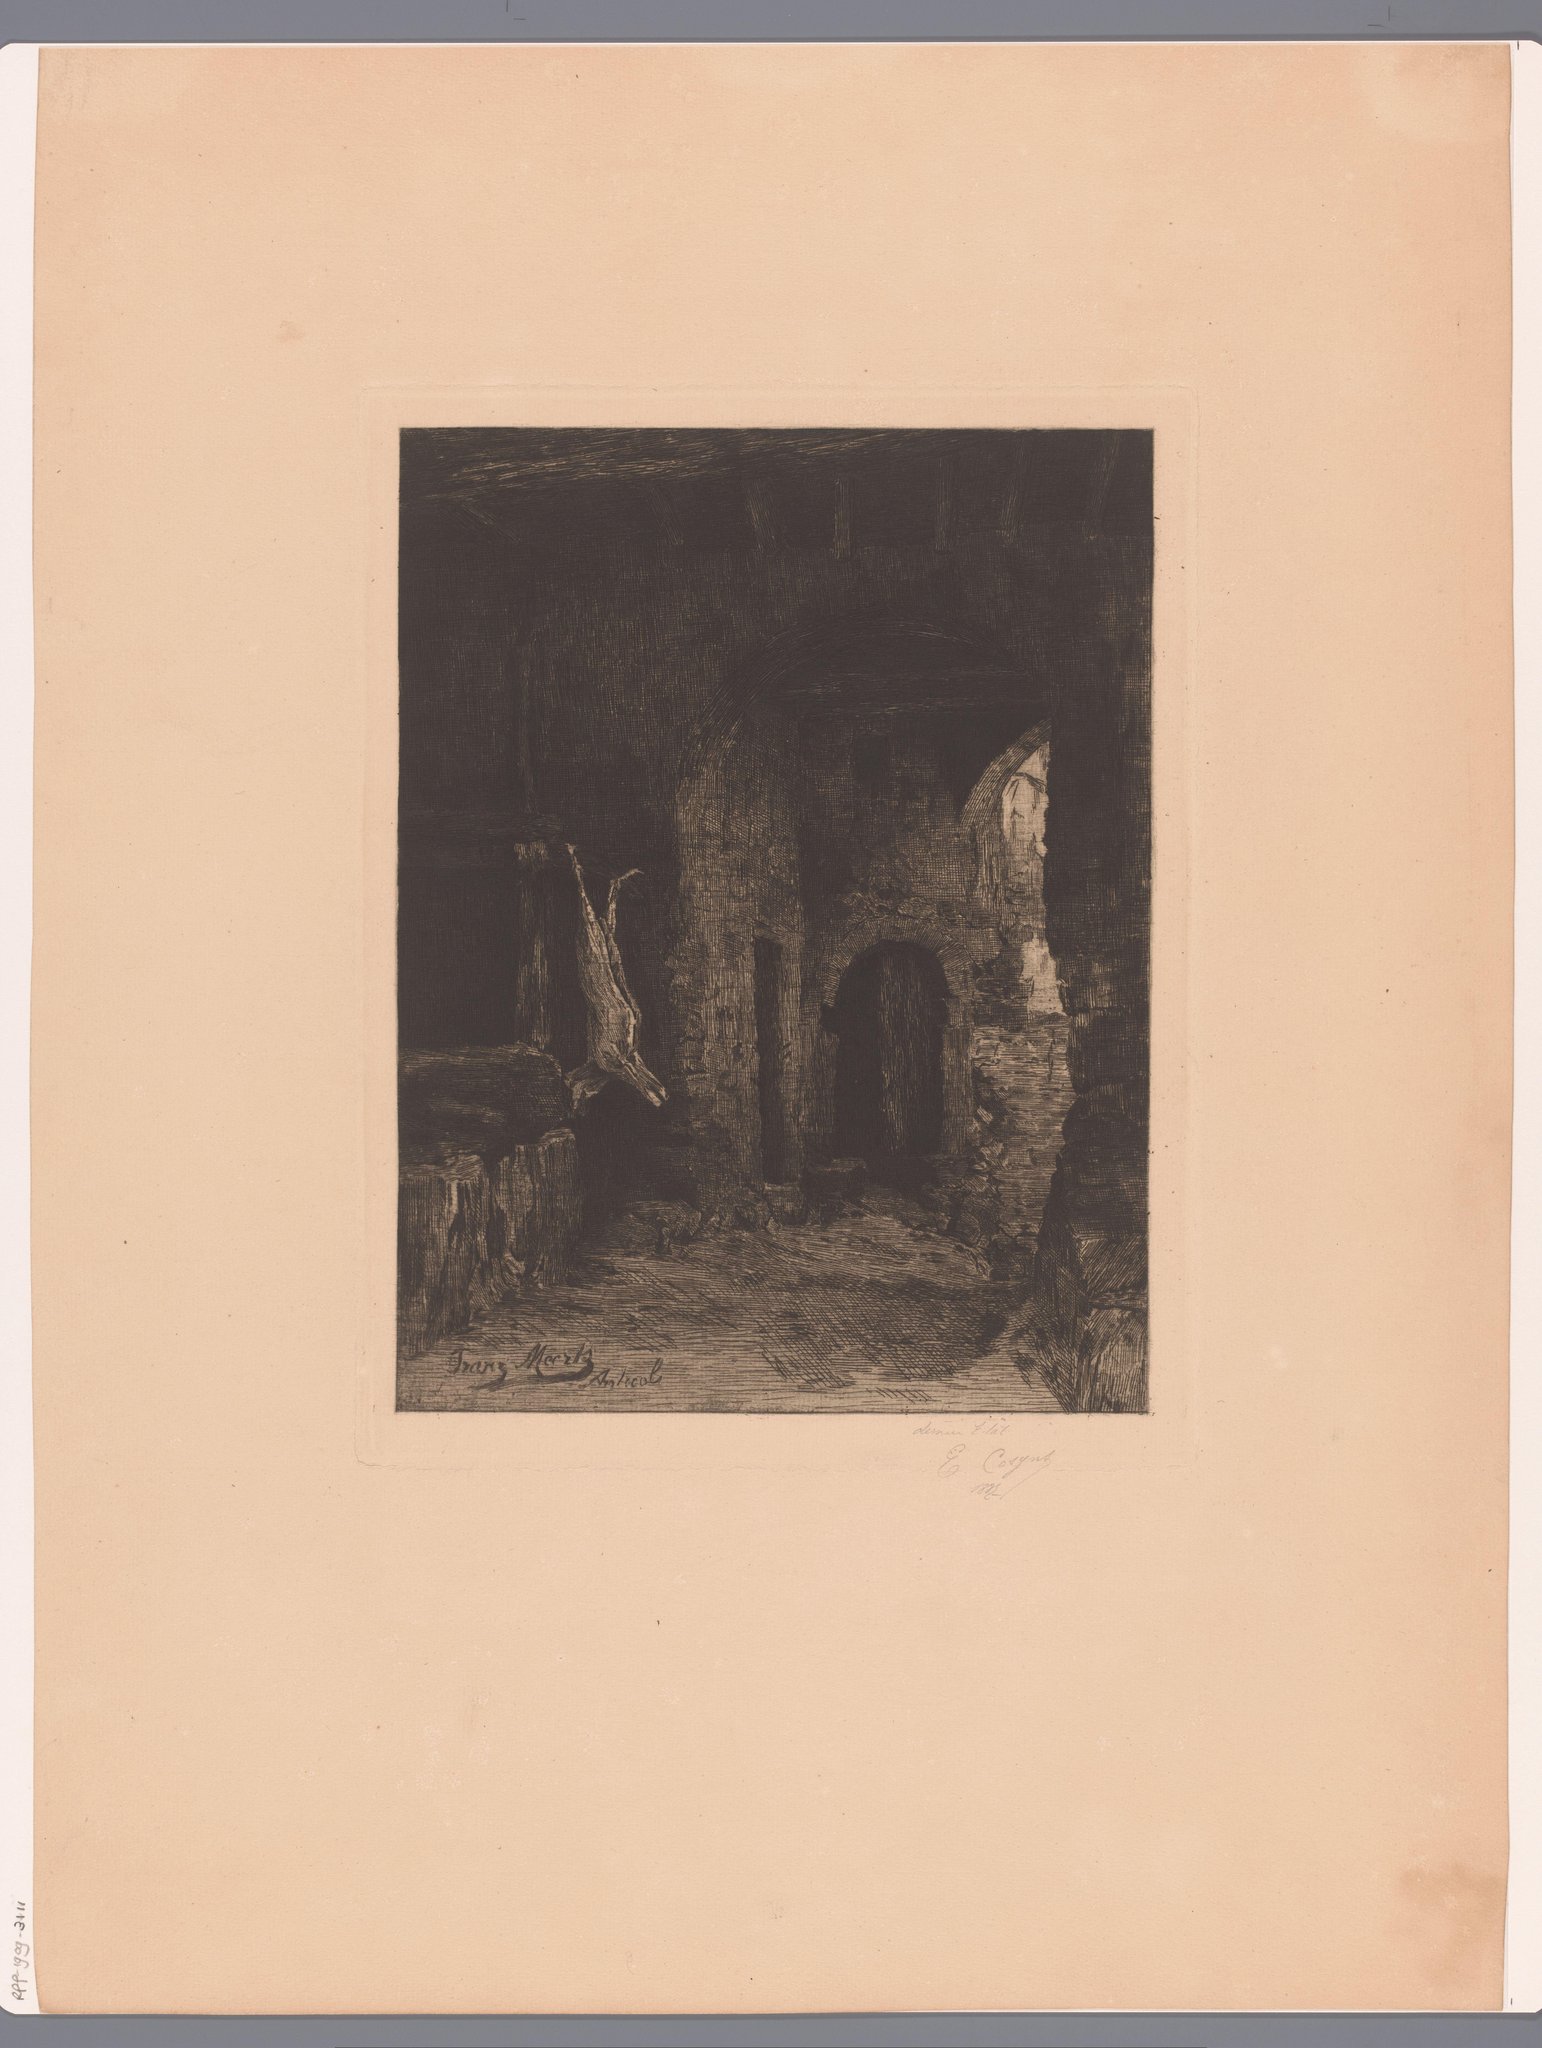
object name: print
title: Gezicht op vervallen bebouwing met opgehangen dier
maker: eugène cosyns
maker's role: print maker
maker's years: 1862-1909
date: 1887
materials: paper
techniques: etching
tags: meat; still life of meat, street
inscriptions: inscription: ‘Dernier Etat’, collector's mark: Lugt 2228